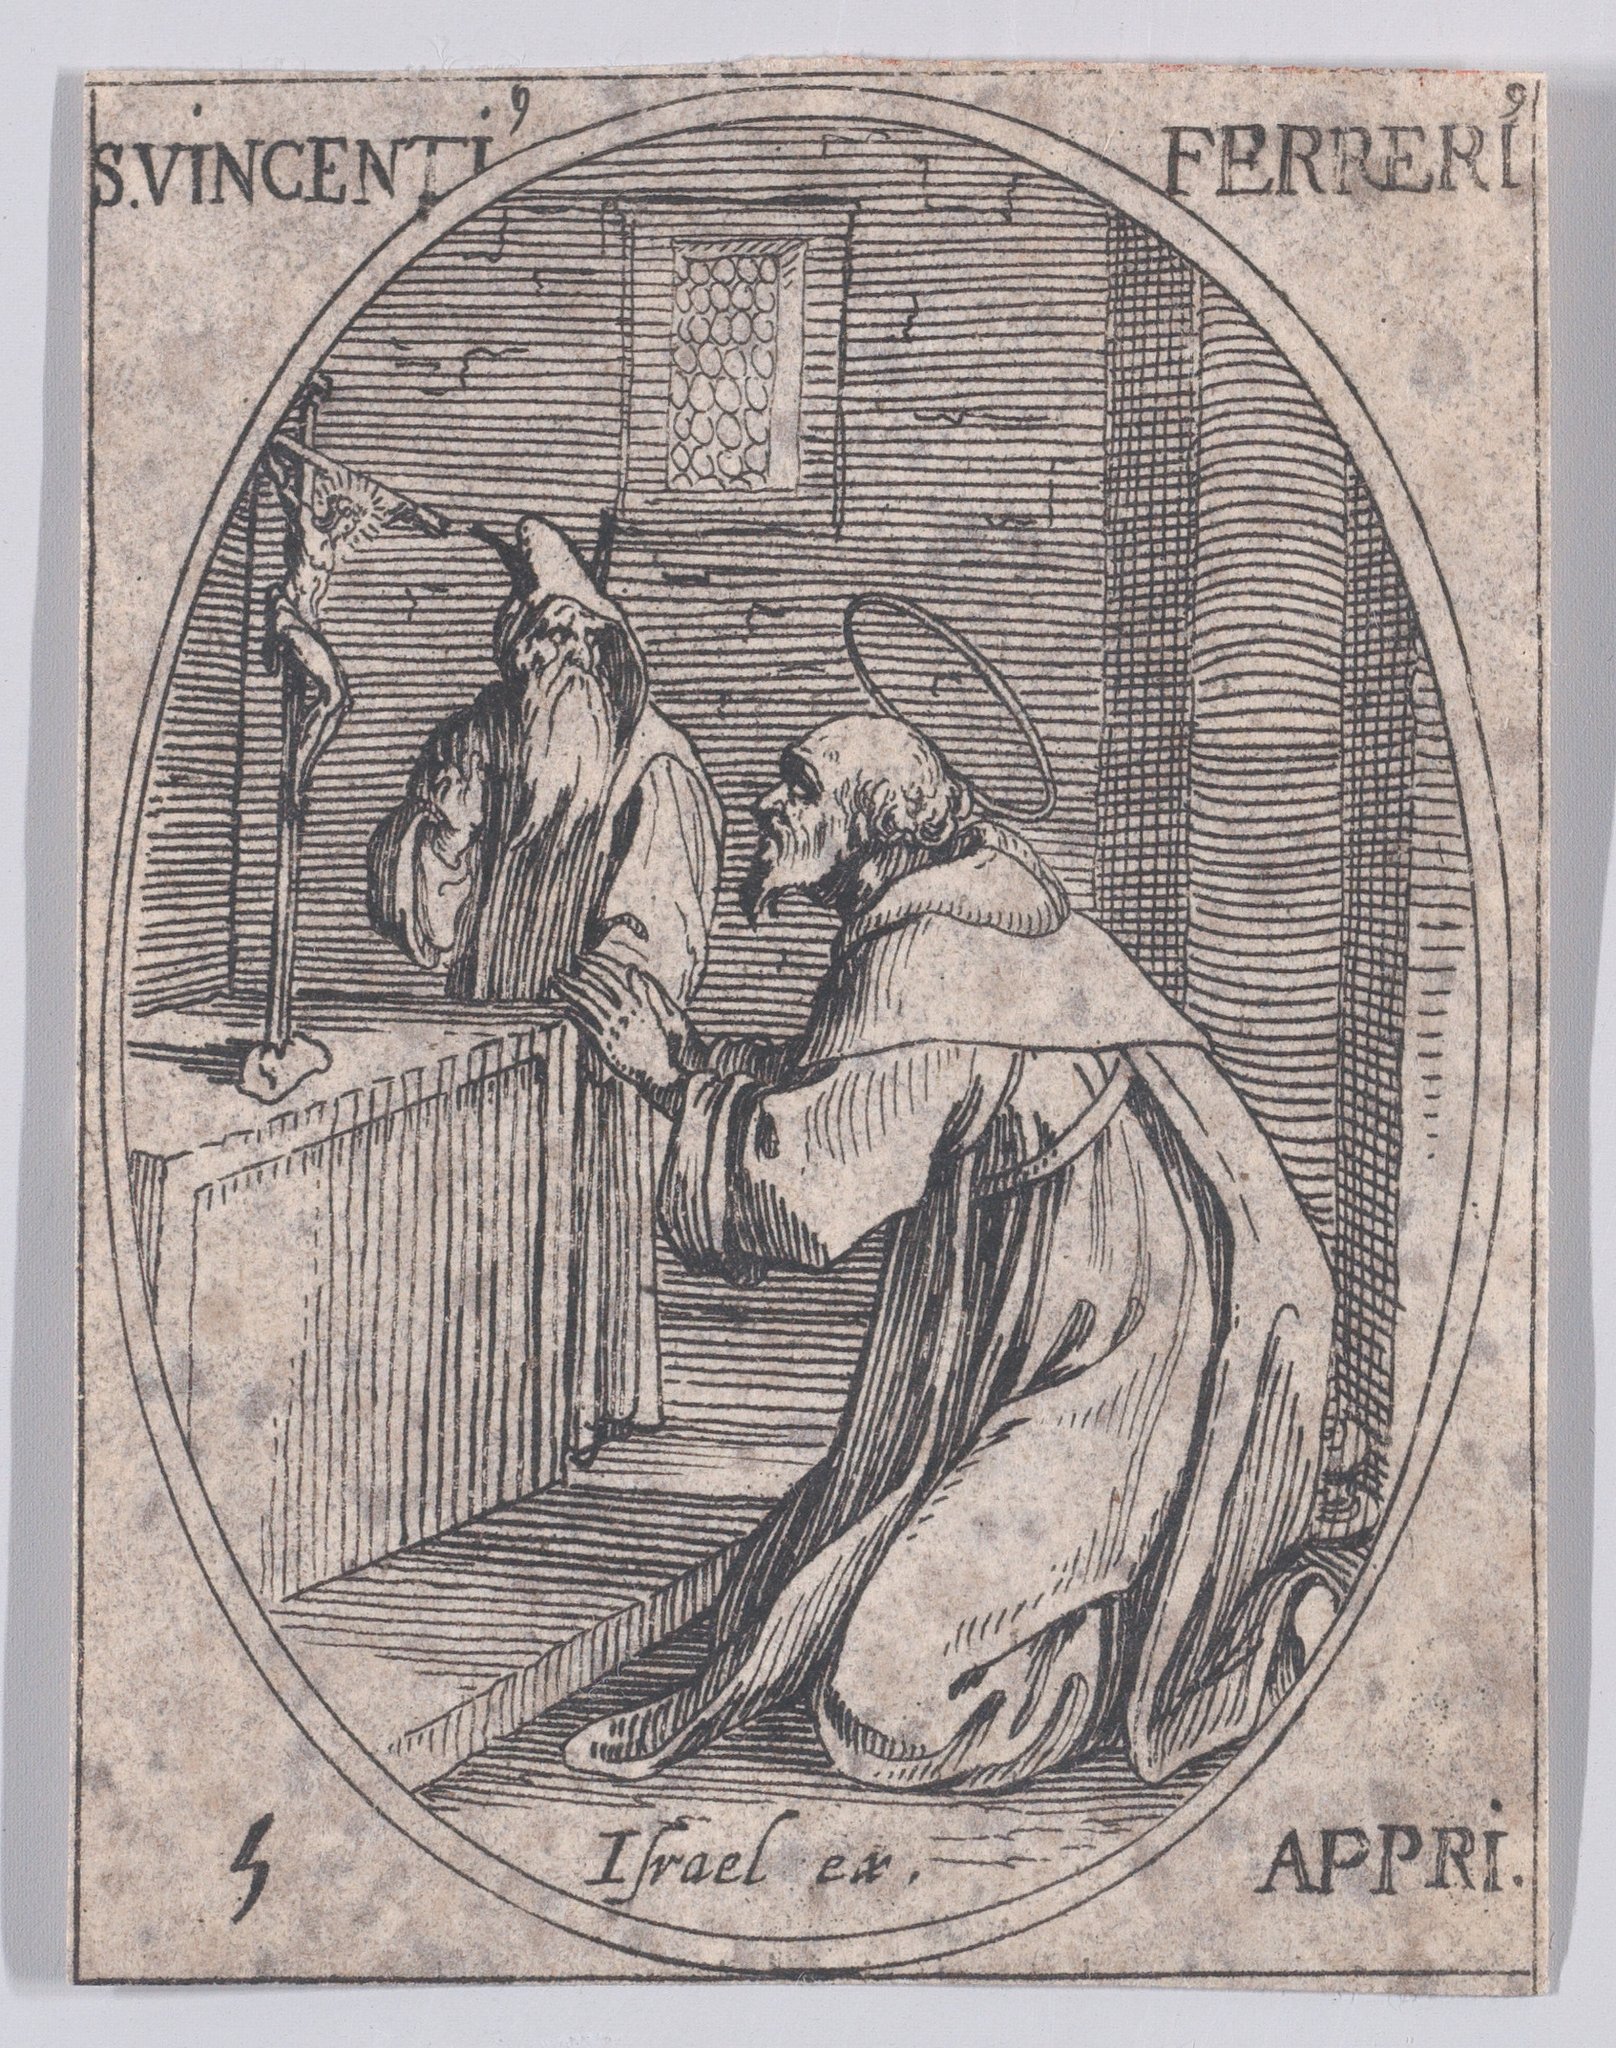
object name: print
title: S. Vincent Ferrier (St. Vincent Ferrer), April 5th, from "Les Images De Tous Les Saincts et Saintes de L'Année" (Images of All of the Saints and Religious Events of the Year)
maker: jacques callot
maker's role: artist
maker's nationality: french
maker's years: 1592-1635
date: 1636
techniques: etching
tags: men,saints